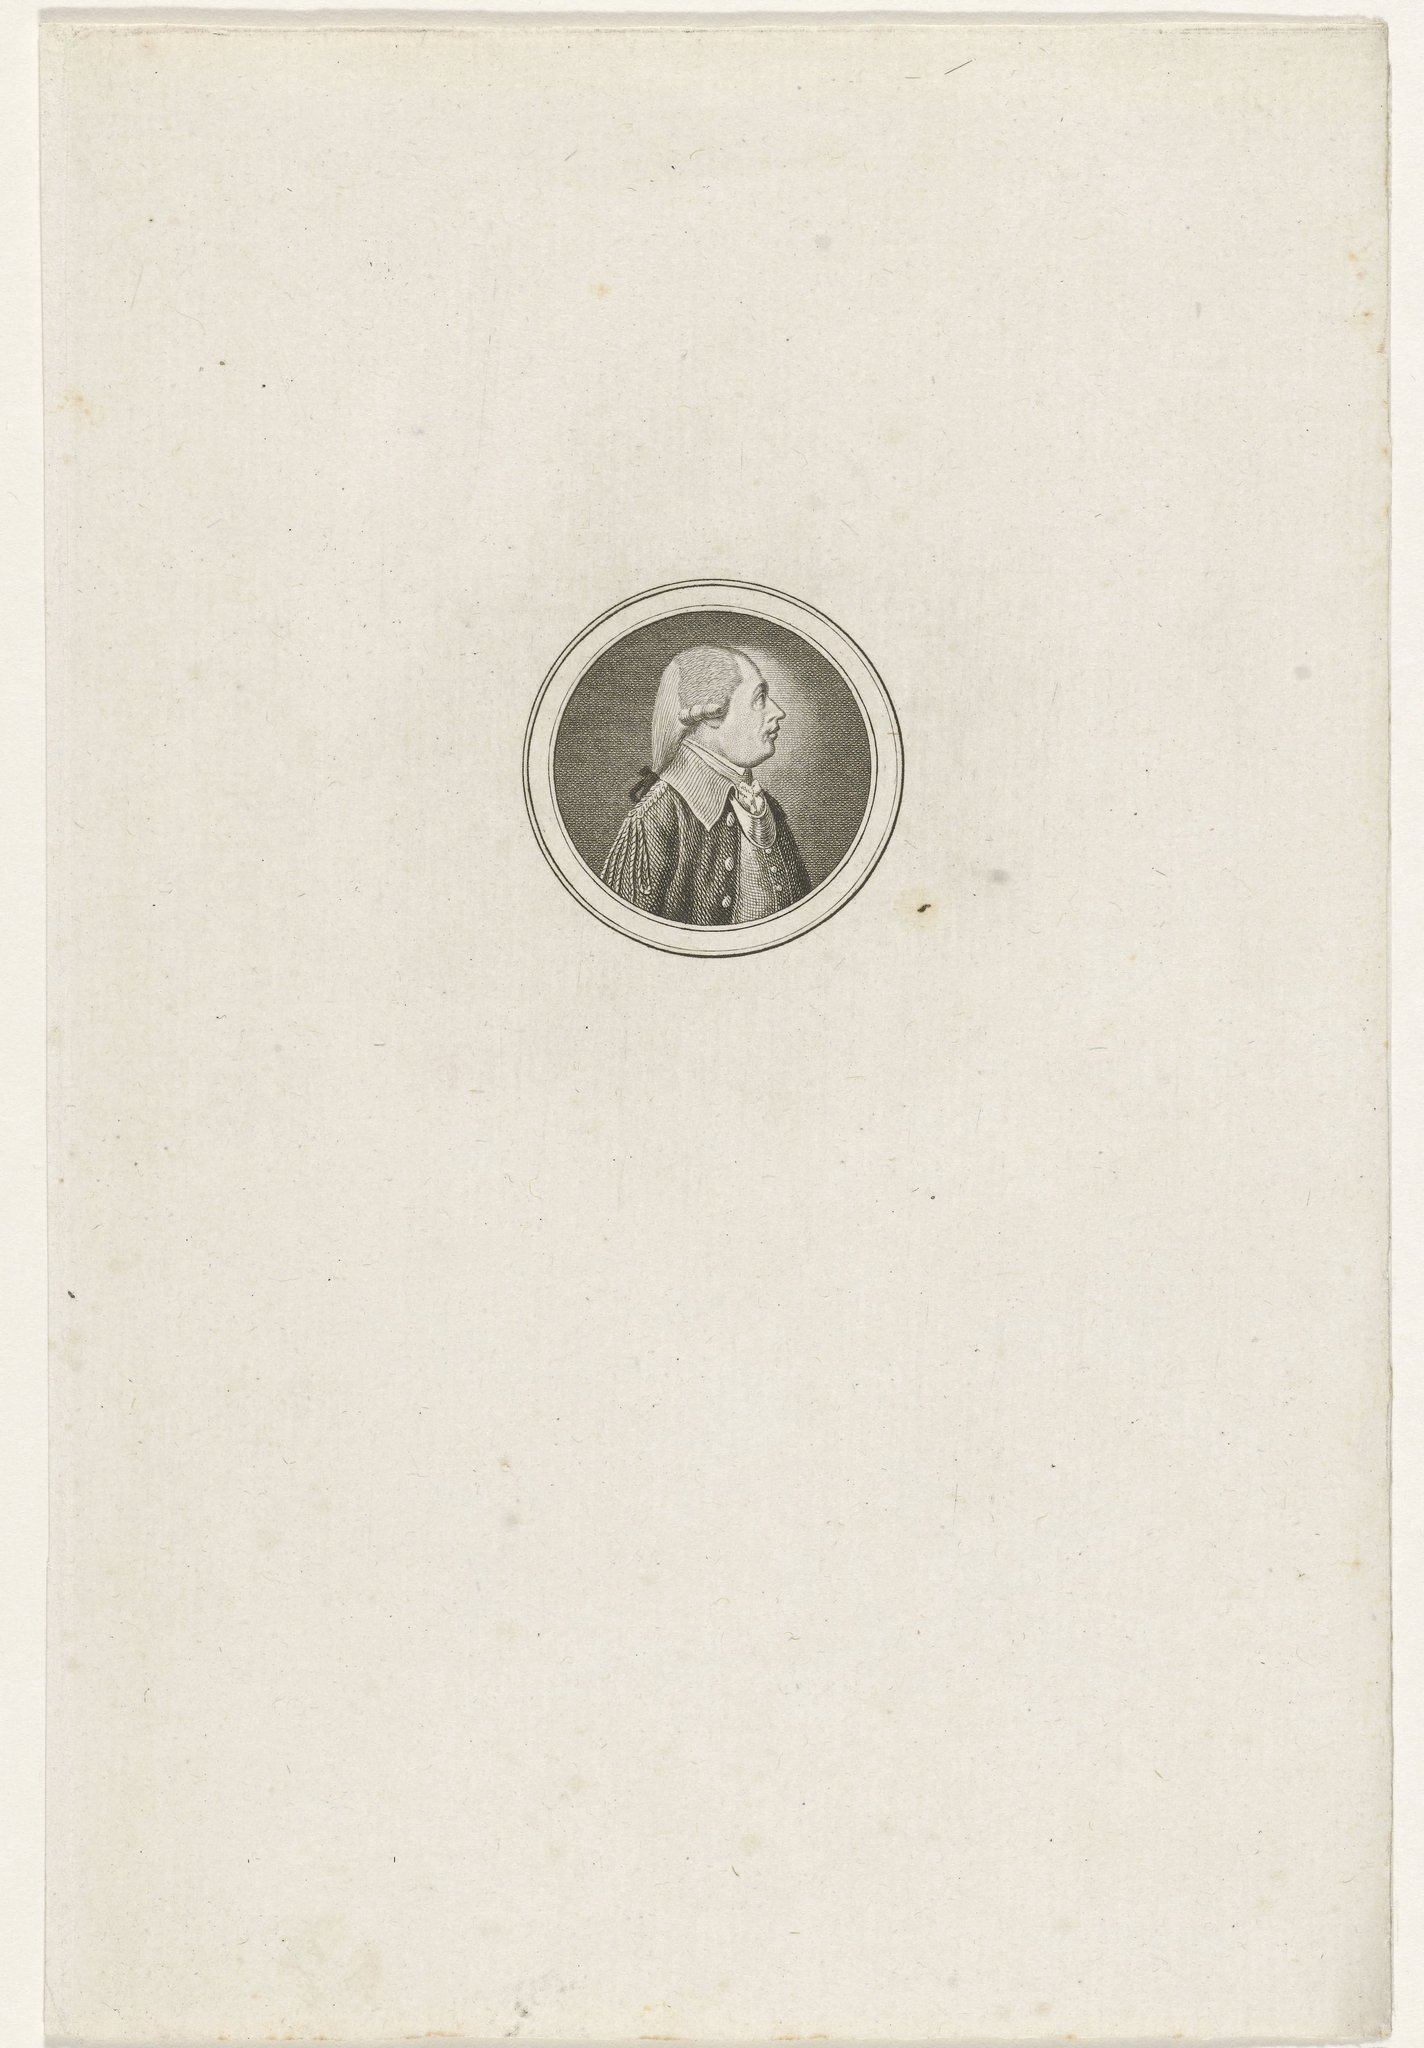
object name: print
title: Portretten van patriotten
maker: abraham jacobsz. hulk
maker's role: print maker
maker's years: 1751-1817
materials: paper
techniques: engraving, etching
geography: paris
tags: leendert van zwyndrecht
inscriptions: collector's mark: Lugt 2228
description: Buste van Leendert van Zwyndrecht en profil naar rechts in een medaillon.